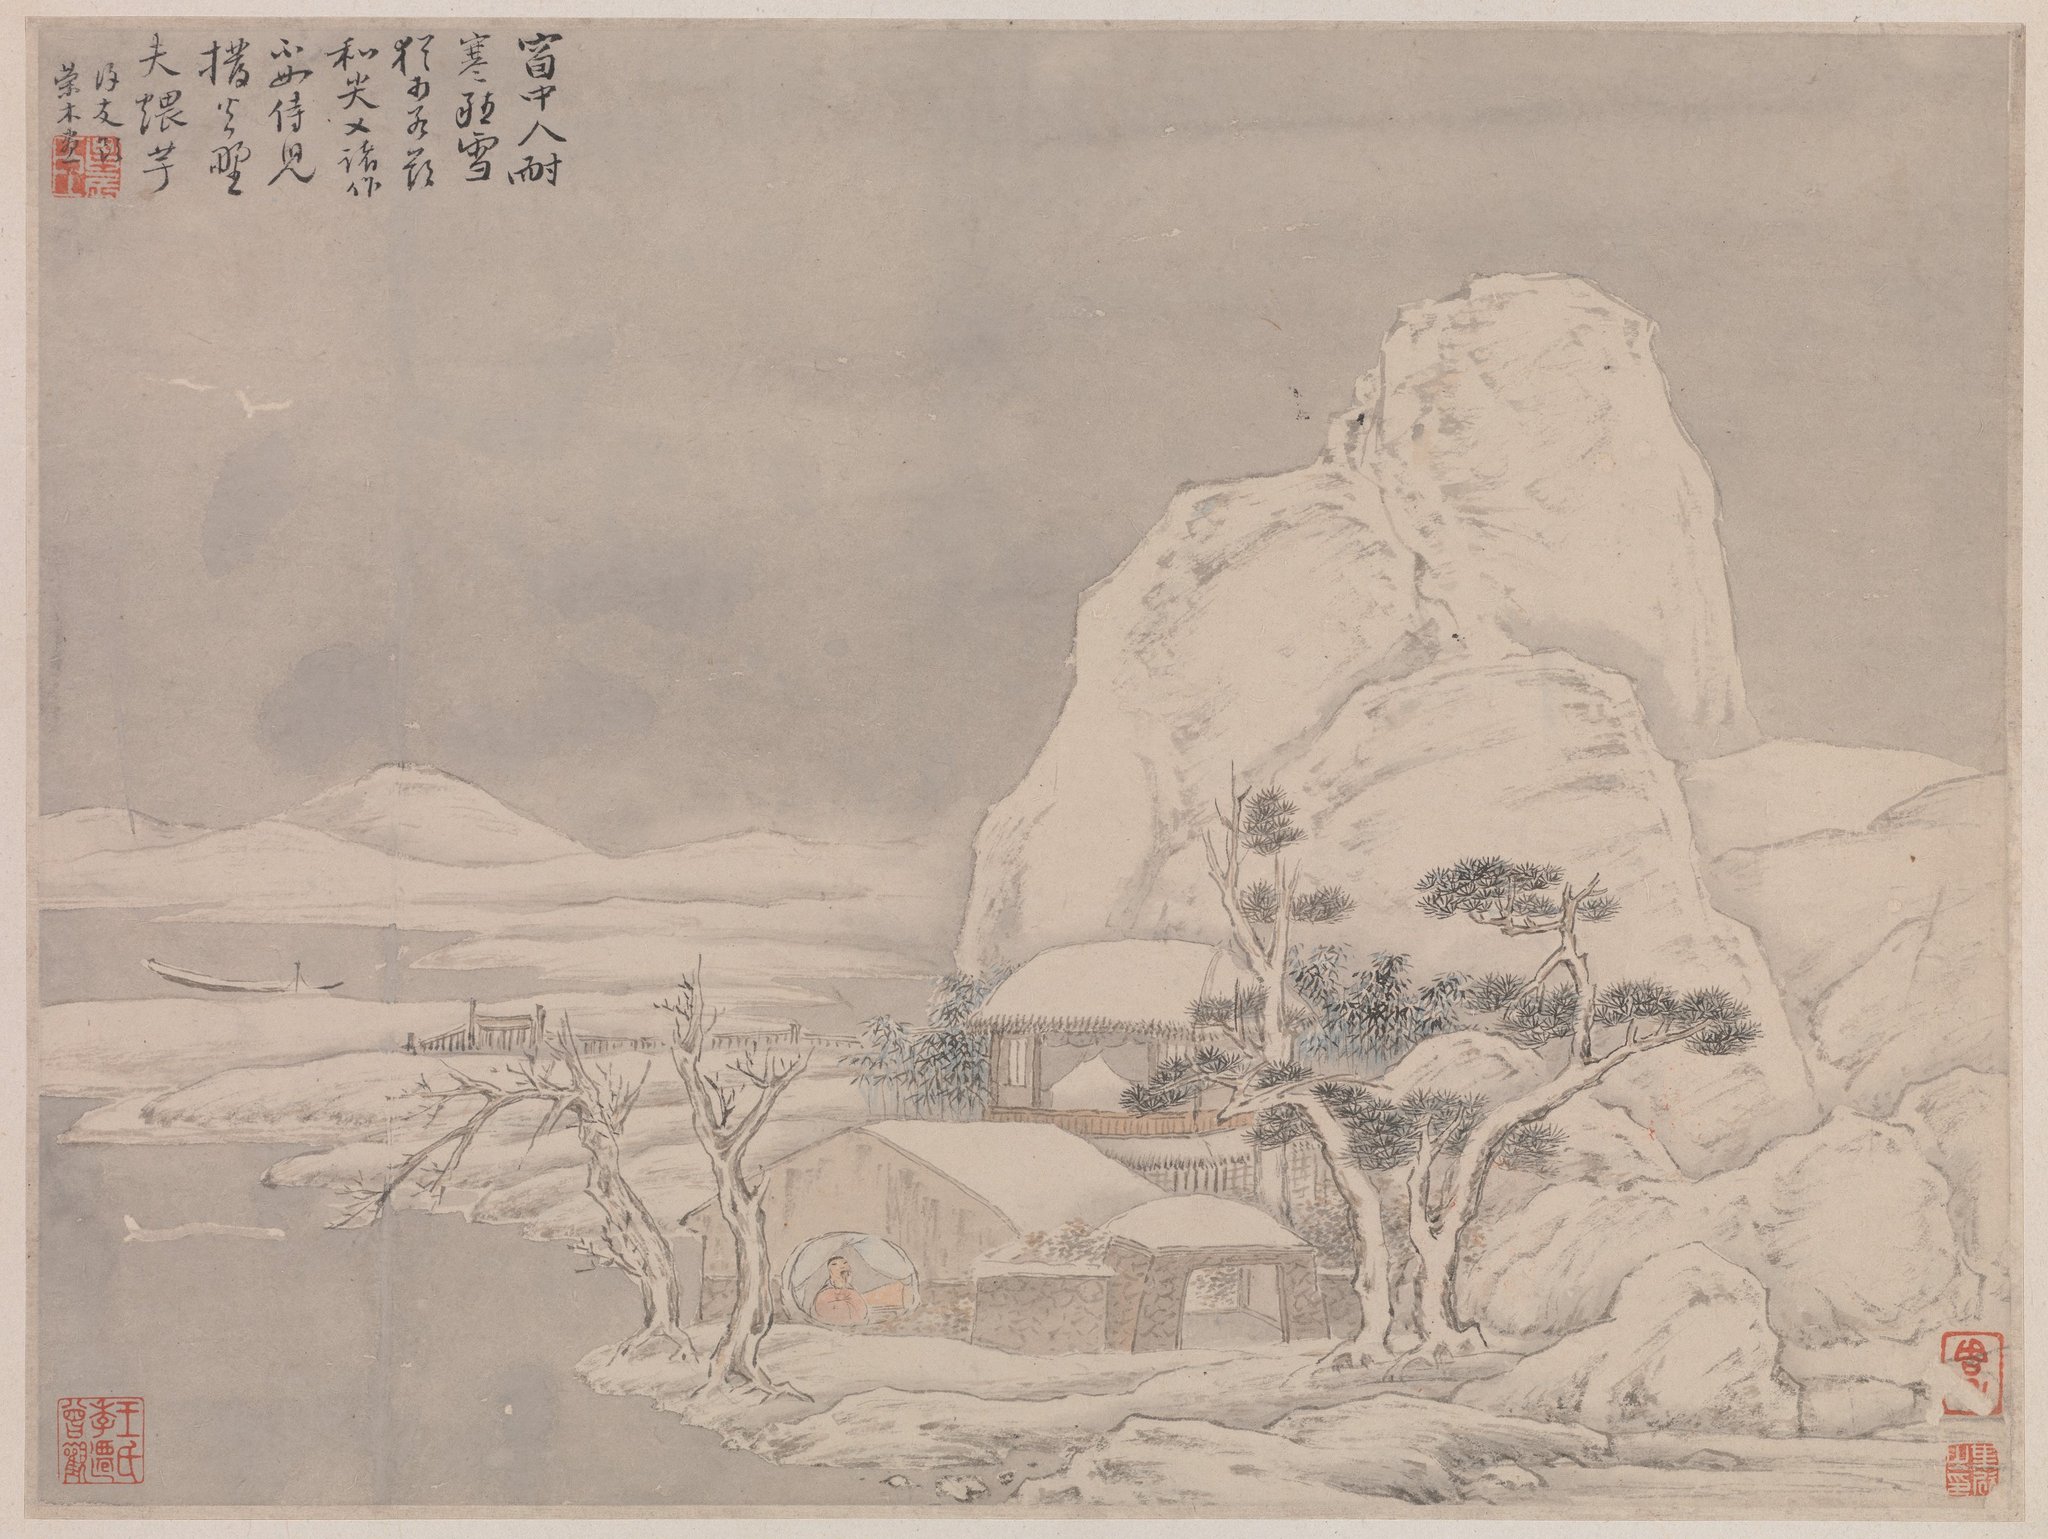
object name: album leaf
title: Snowscape, leaf from Album for Zhou Lianggong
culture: chinese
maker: ye xin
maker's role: artist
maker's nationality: chinese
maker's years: 1640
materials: ink, paper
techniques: calligraphy, painting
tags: mountains,landscapes,snow